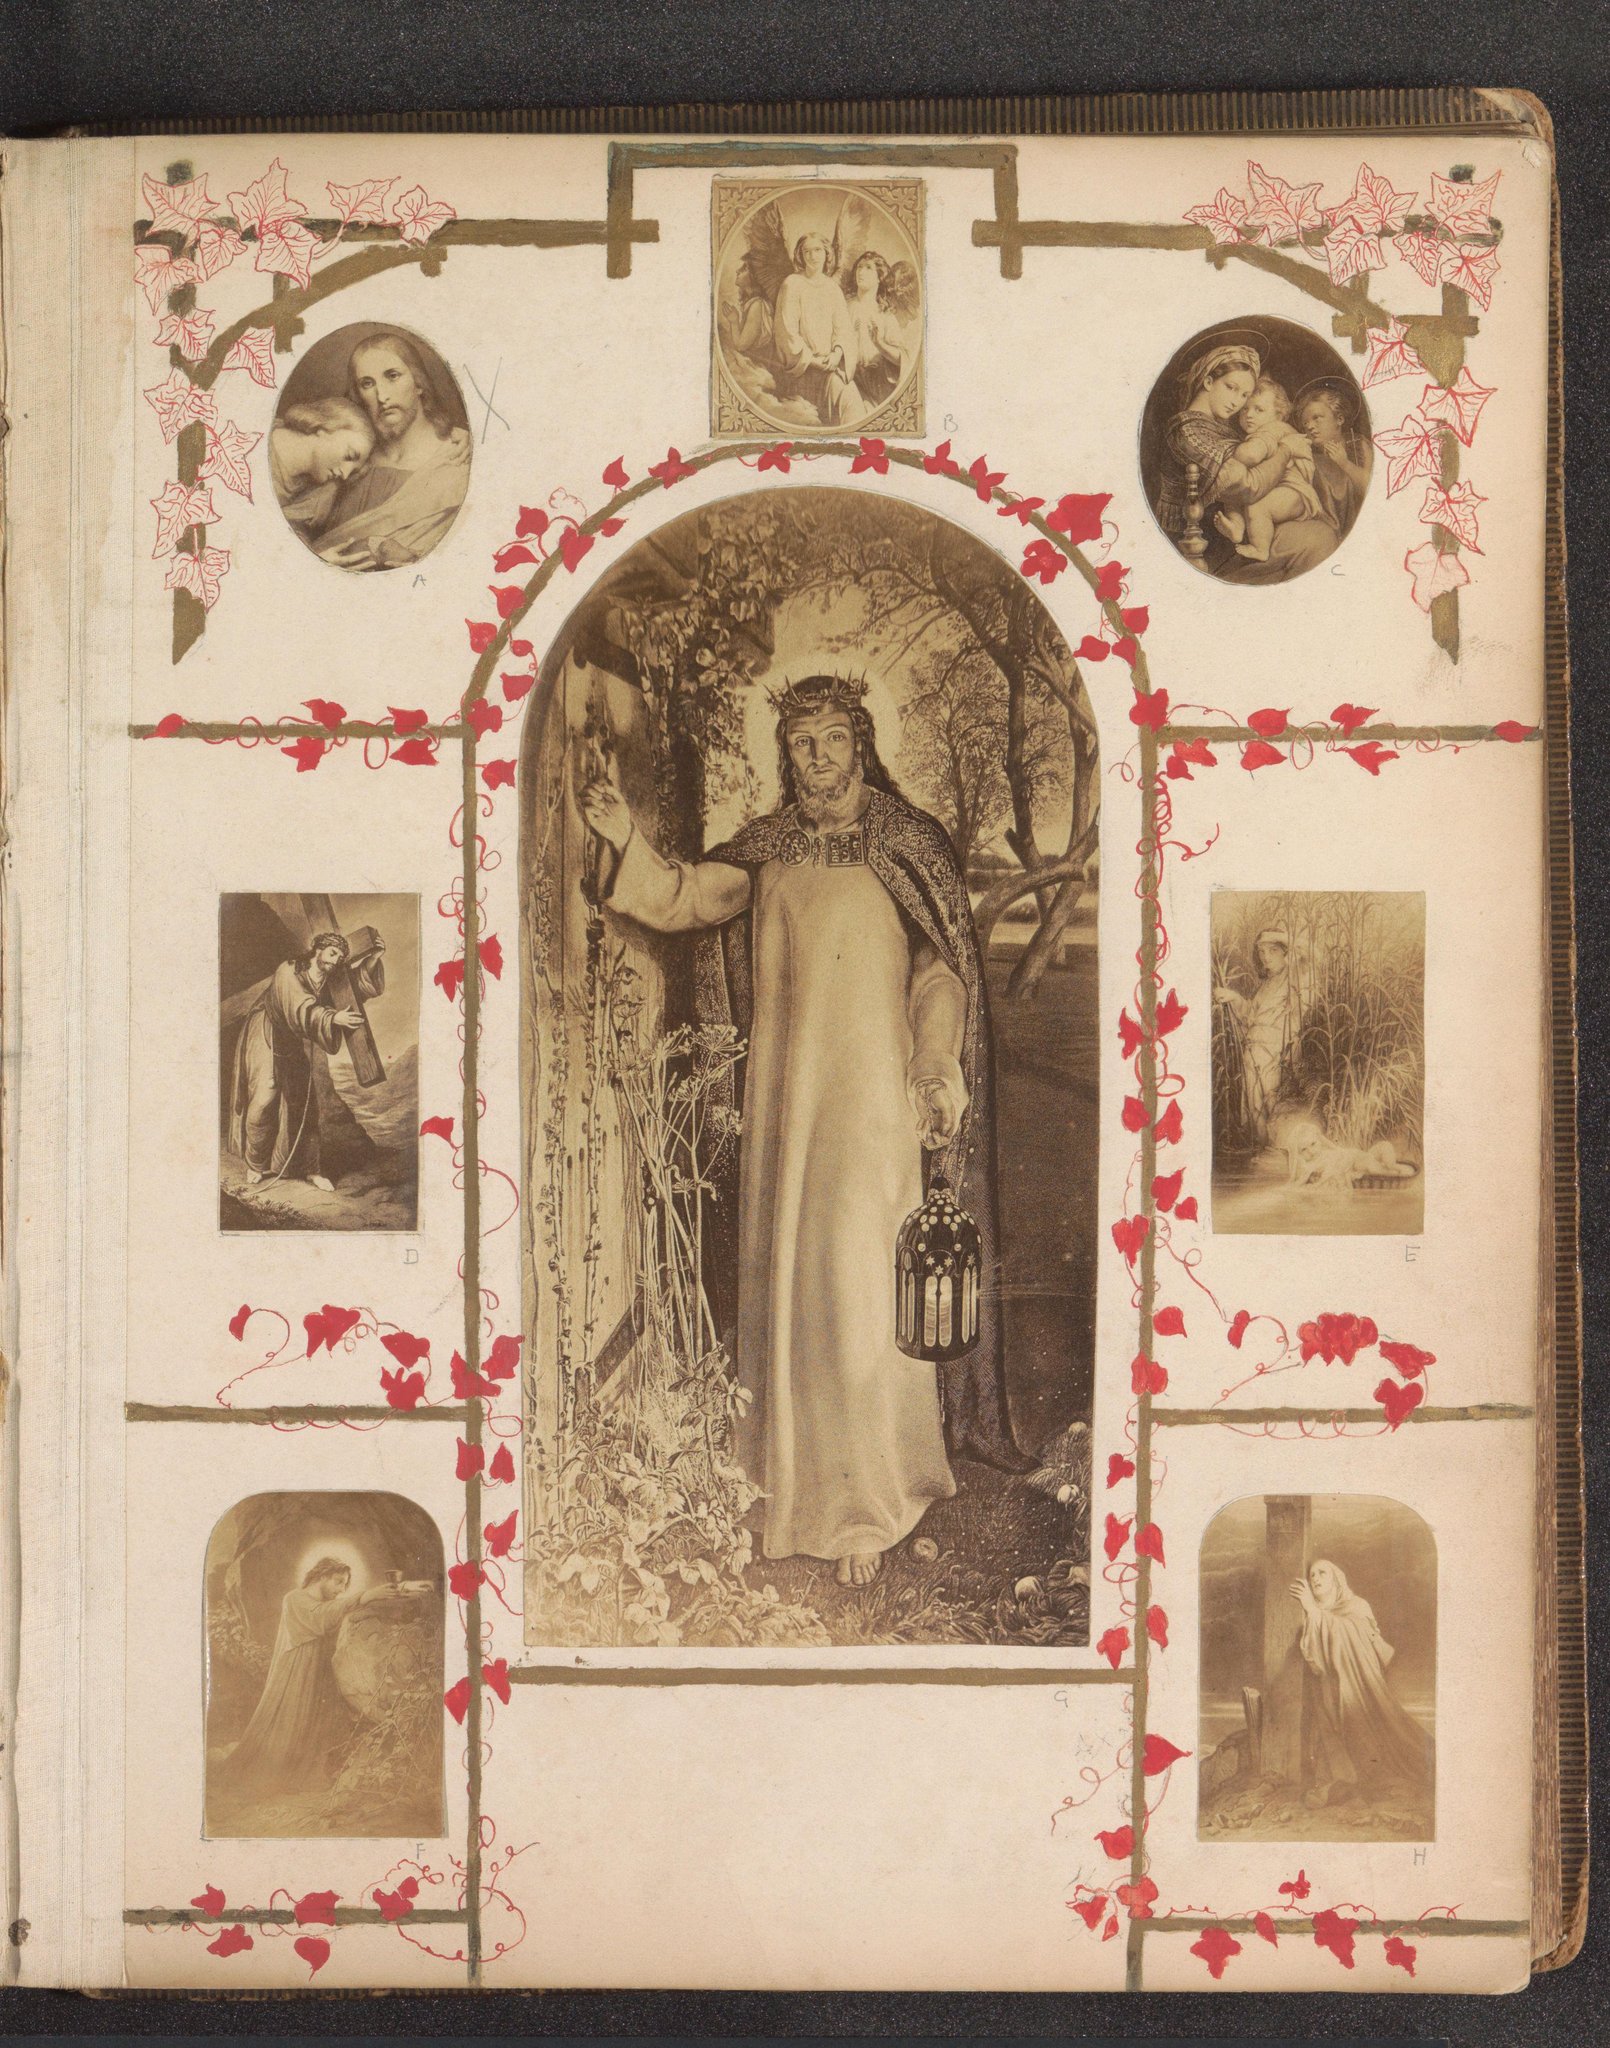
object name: photograph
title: Fotoreproductie van (vermoedelijk) een prent van Mozes in een mand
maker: Anonymous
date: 1850-1870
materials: paper, photographic support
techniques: albumen print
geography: england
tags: the finding of moses: pharaoh's daughter comes to bathe with her maidens in the river and discovers the child floating on the water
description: Onderdeel van Album met foto's van bezienswaardigheden en landschappen in Engeland en van kunst.